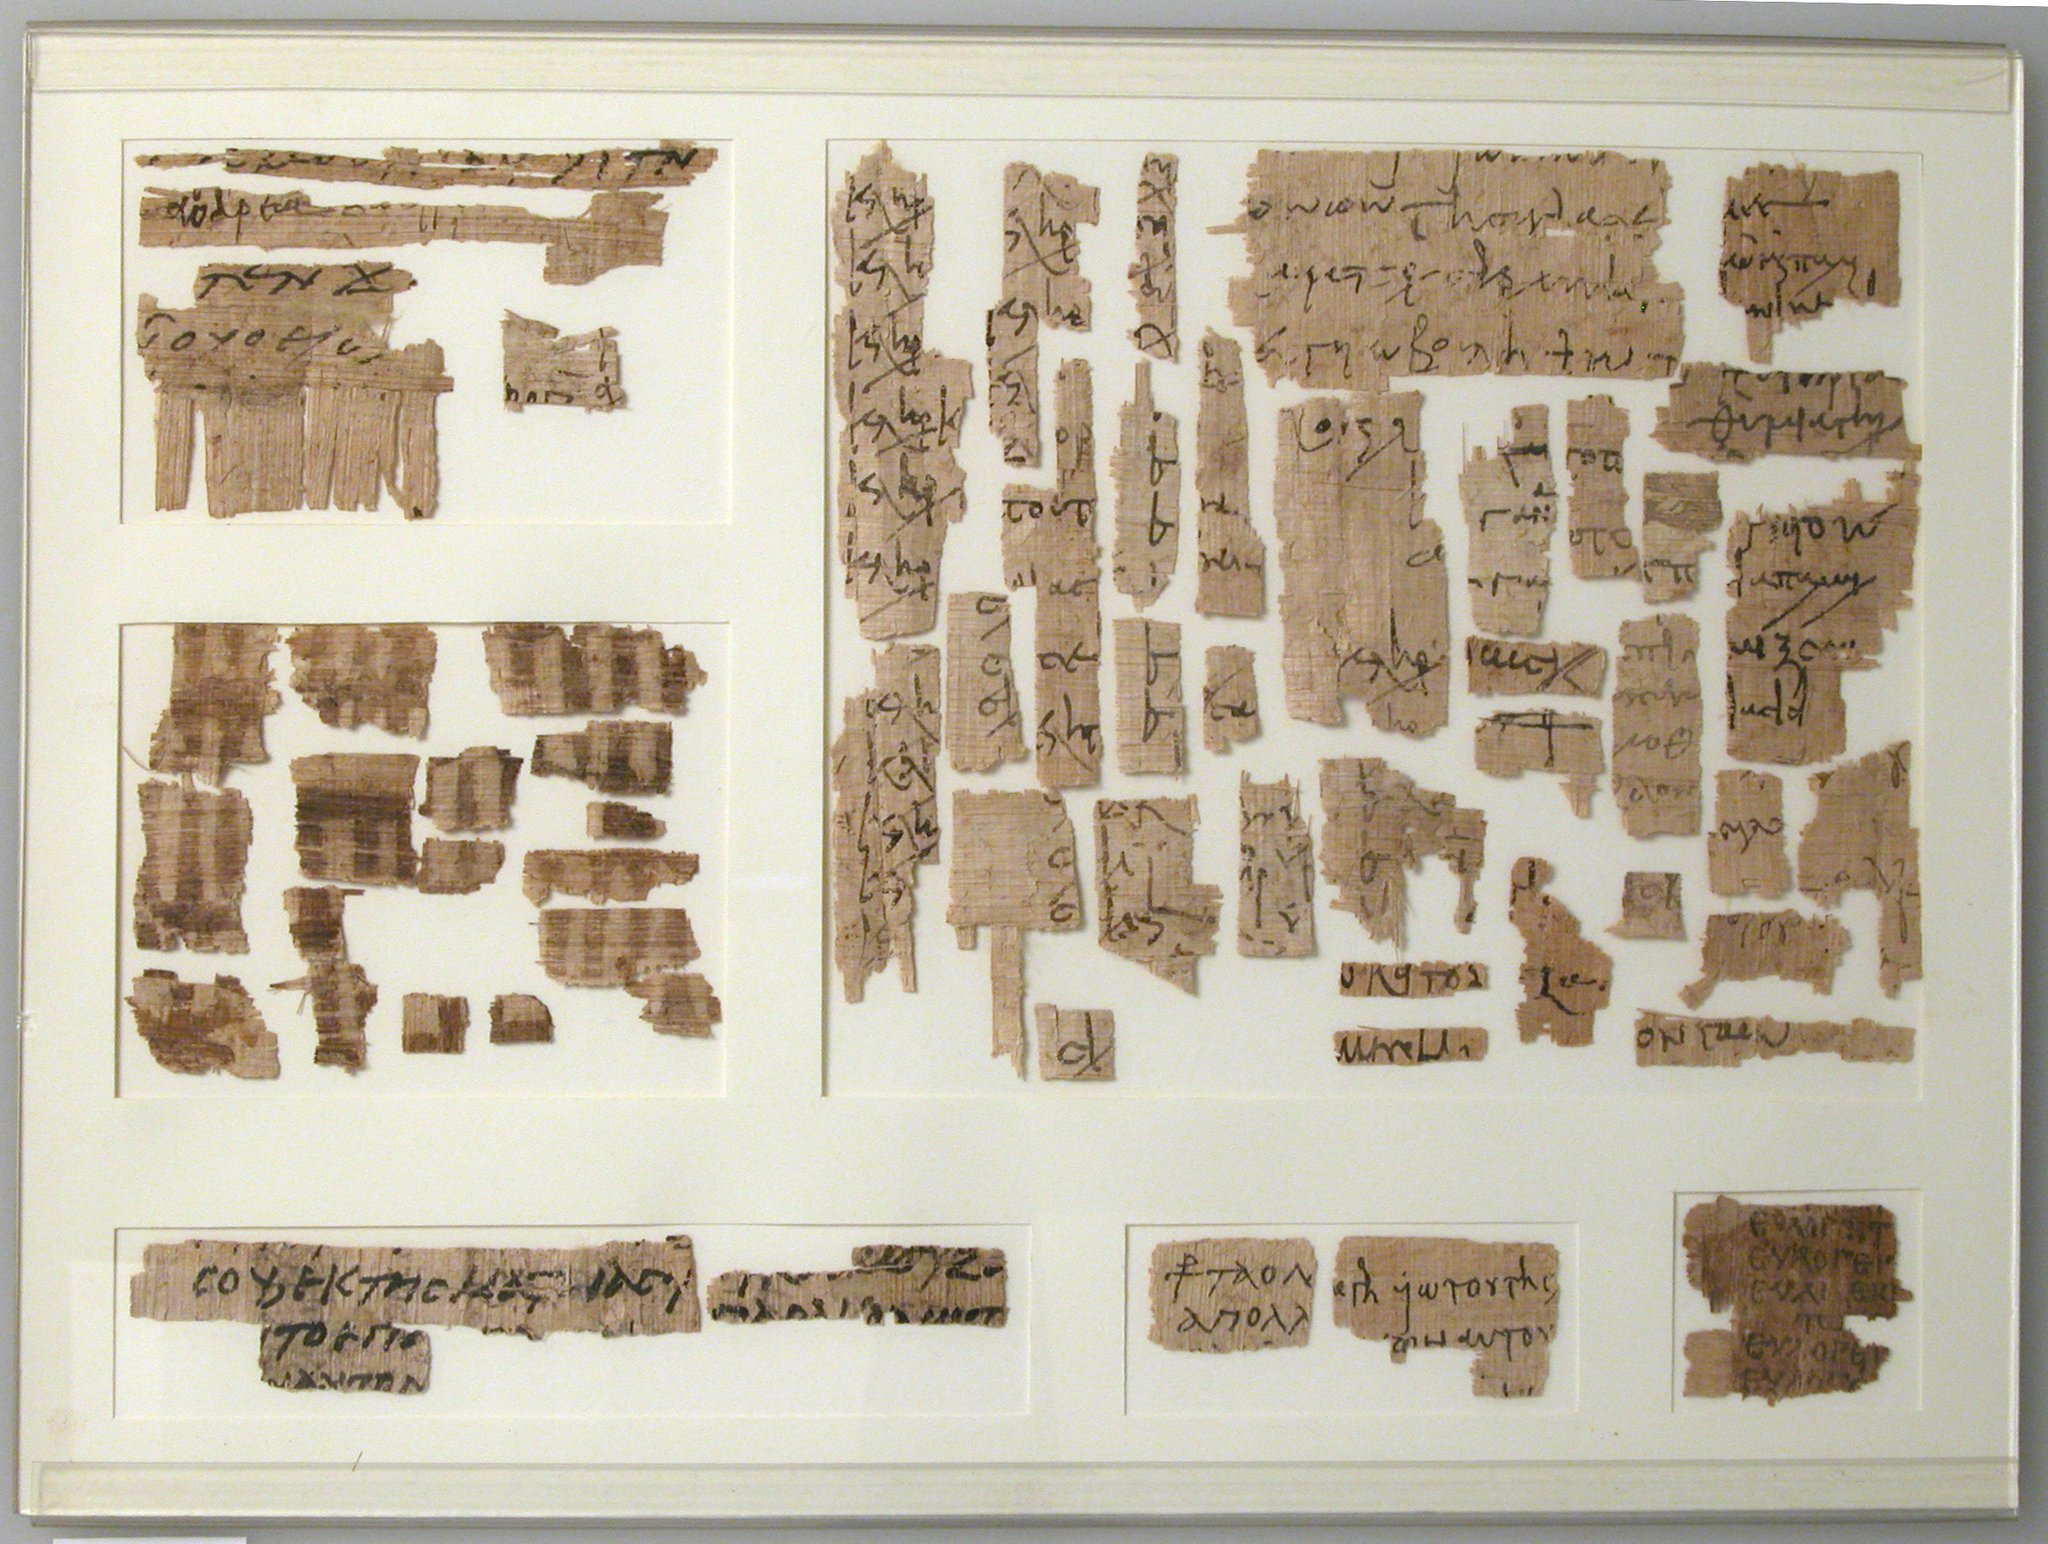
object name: fragment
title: Papyri Fragments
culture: coptic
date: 601-700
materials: ink, papyrus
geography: egypt